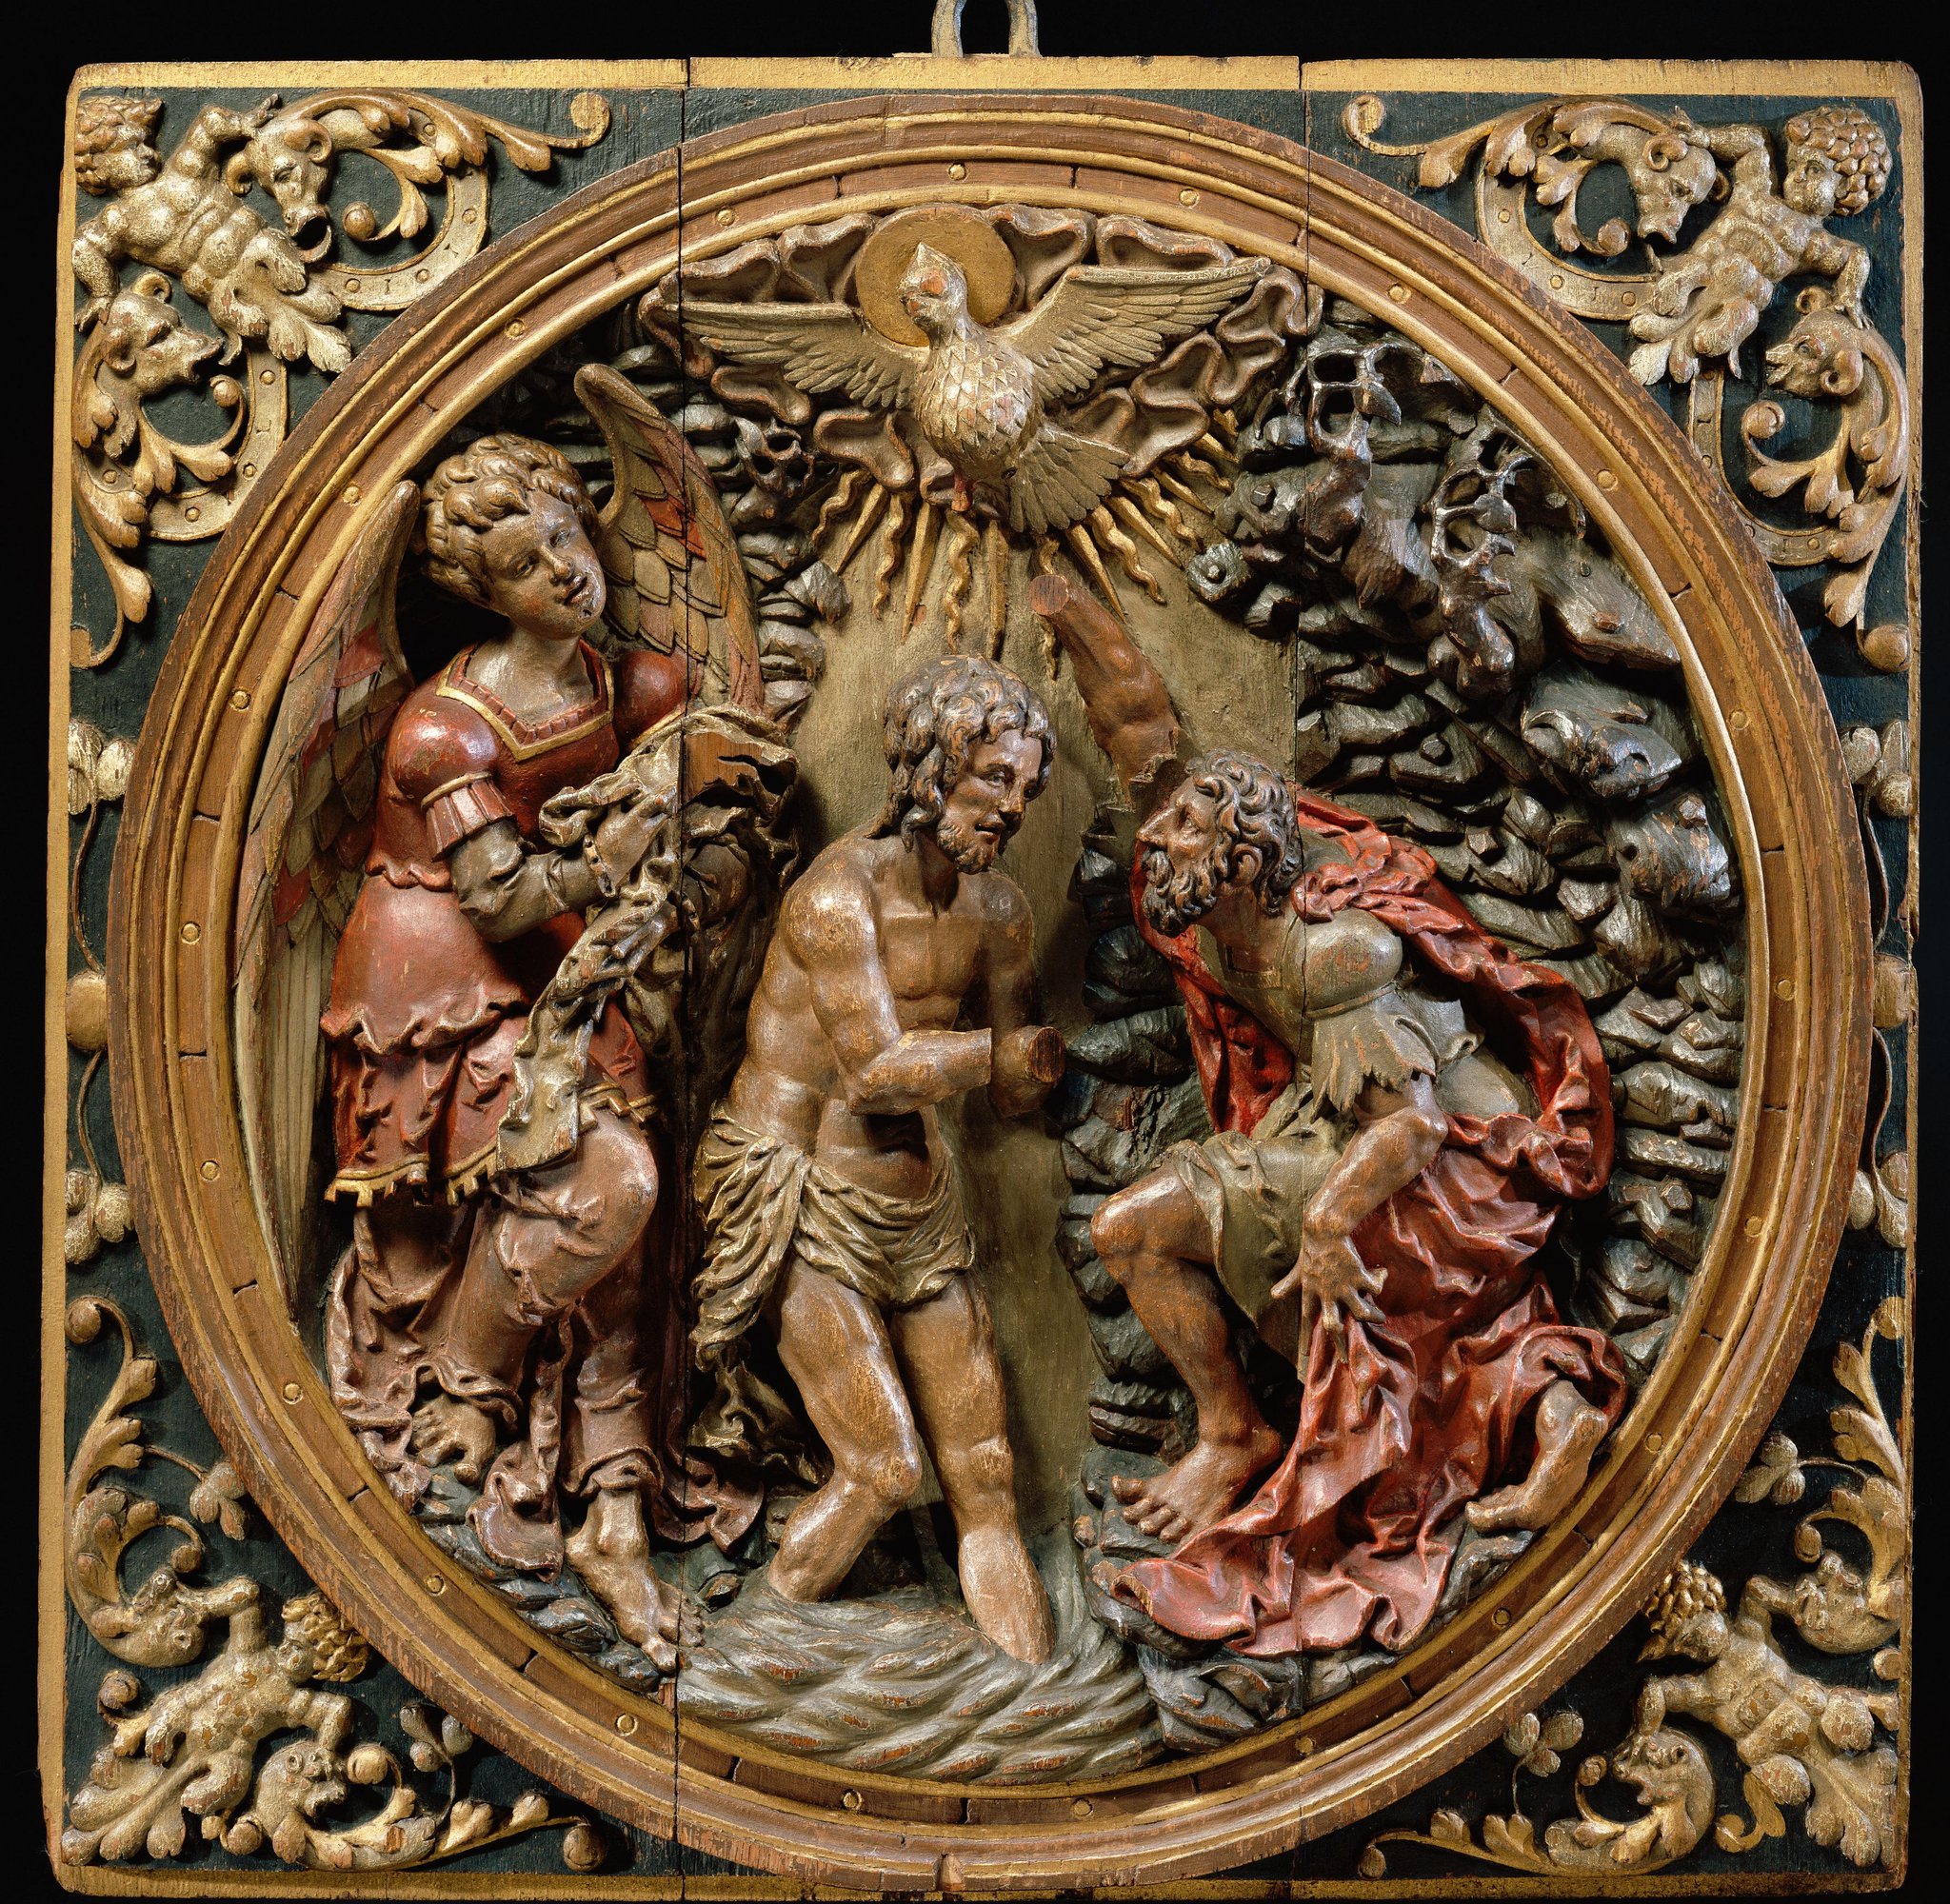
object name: sculpture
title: The Baptism of Christ in the River Jordan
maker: Anonymous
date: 1535-1565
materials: wood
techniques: polychromy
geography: gouda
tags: gouda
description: In het midden staat de naar rechts gewende Christus, met lendendoek, in de rivier voor Johannes. De knielt tegenover hem op de rotsachtige oever, heeft de rechterarm geheven en houdt met de linker zijn kleed op. Links van Christus staat een engel, die zijn kleed draagt, boven hem zweeft in de gedaante van een duif de Heilige Geest tegen een achtergrond van wolkjes, waaruit stralen schieten. In het opgaande landschap achter Johannes enkele bomen. Hij draagt een kleed met gerafelde pofmouwen en een van de rechter schouder afhangende mantel; de engel een kleedmet lange mouwen, waaroverheen een tweemaal gegord kort jak met pofmouwen, dat onderaan met een kantelenrand en langs de hals met een regelmatig ingesneden randje is afgezet. De voorstelling is gevat in een ronde omlijsting en maakt deel uit van een vierkant paneel, waarvan elke hoek wordt gevuld door een decoratief gevormde putto, die beide handen op een uit een bloemmotief voortkomende dierenkop legt. Bij beide bovenste putti verbindt een sleufband het onderlijf met een bladornament.